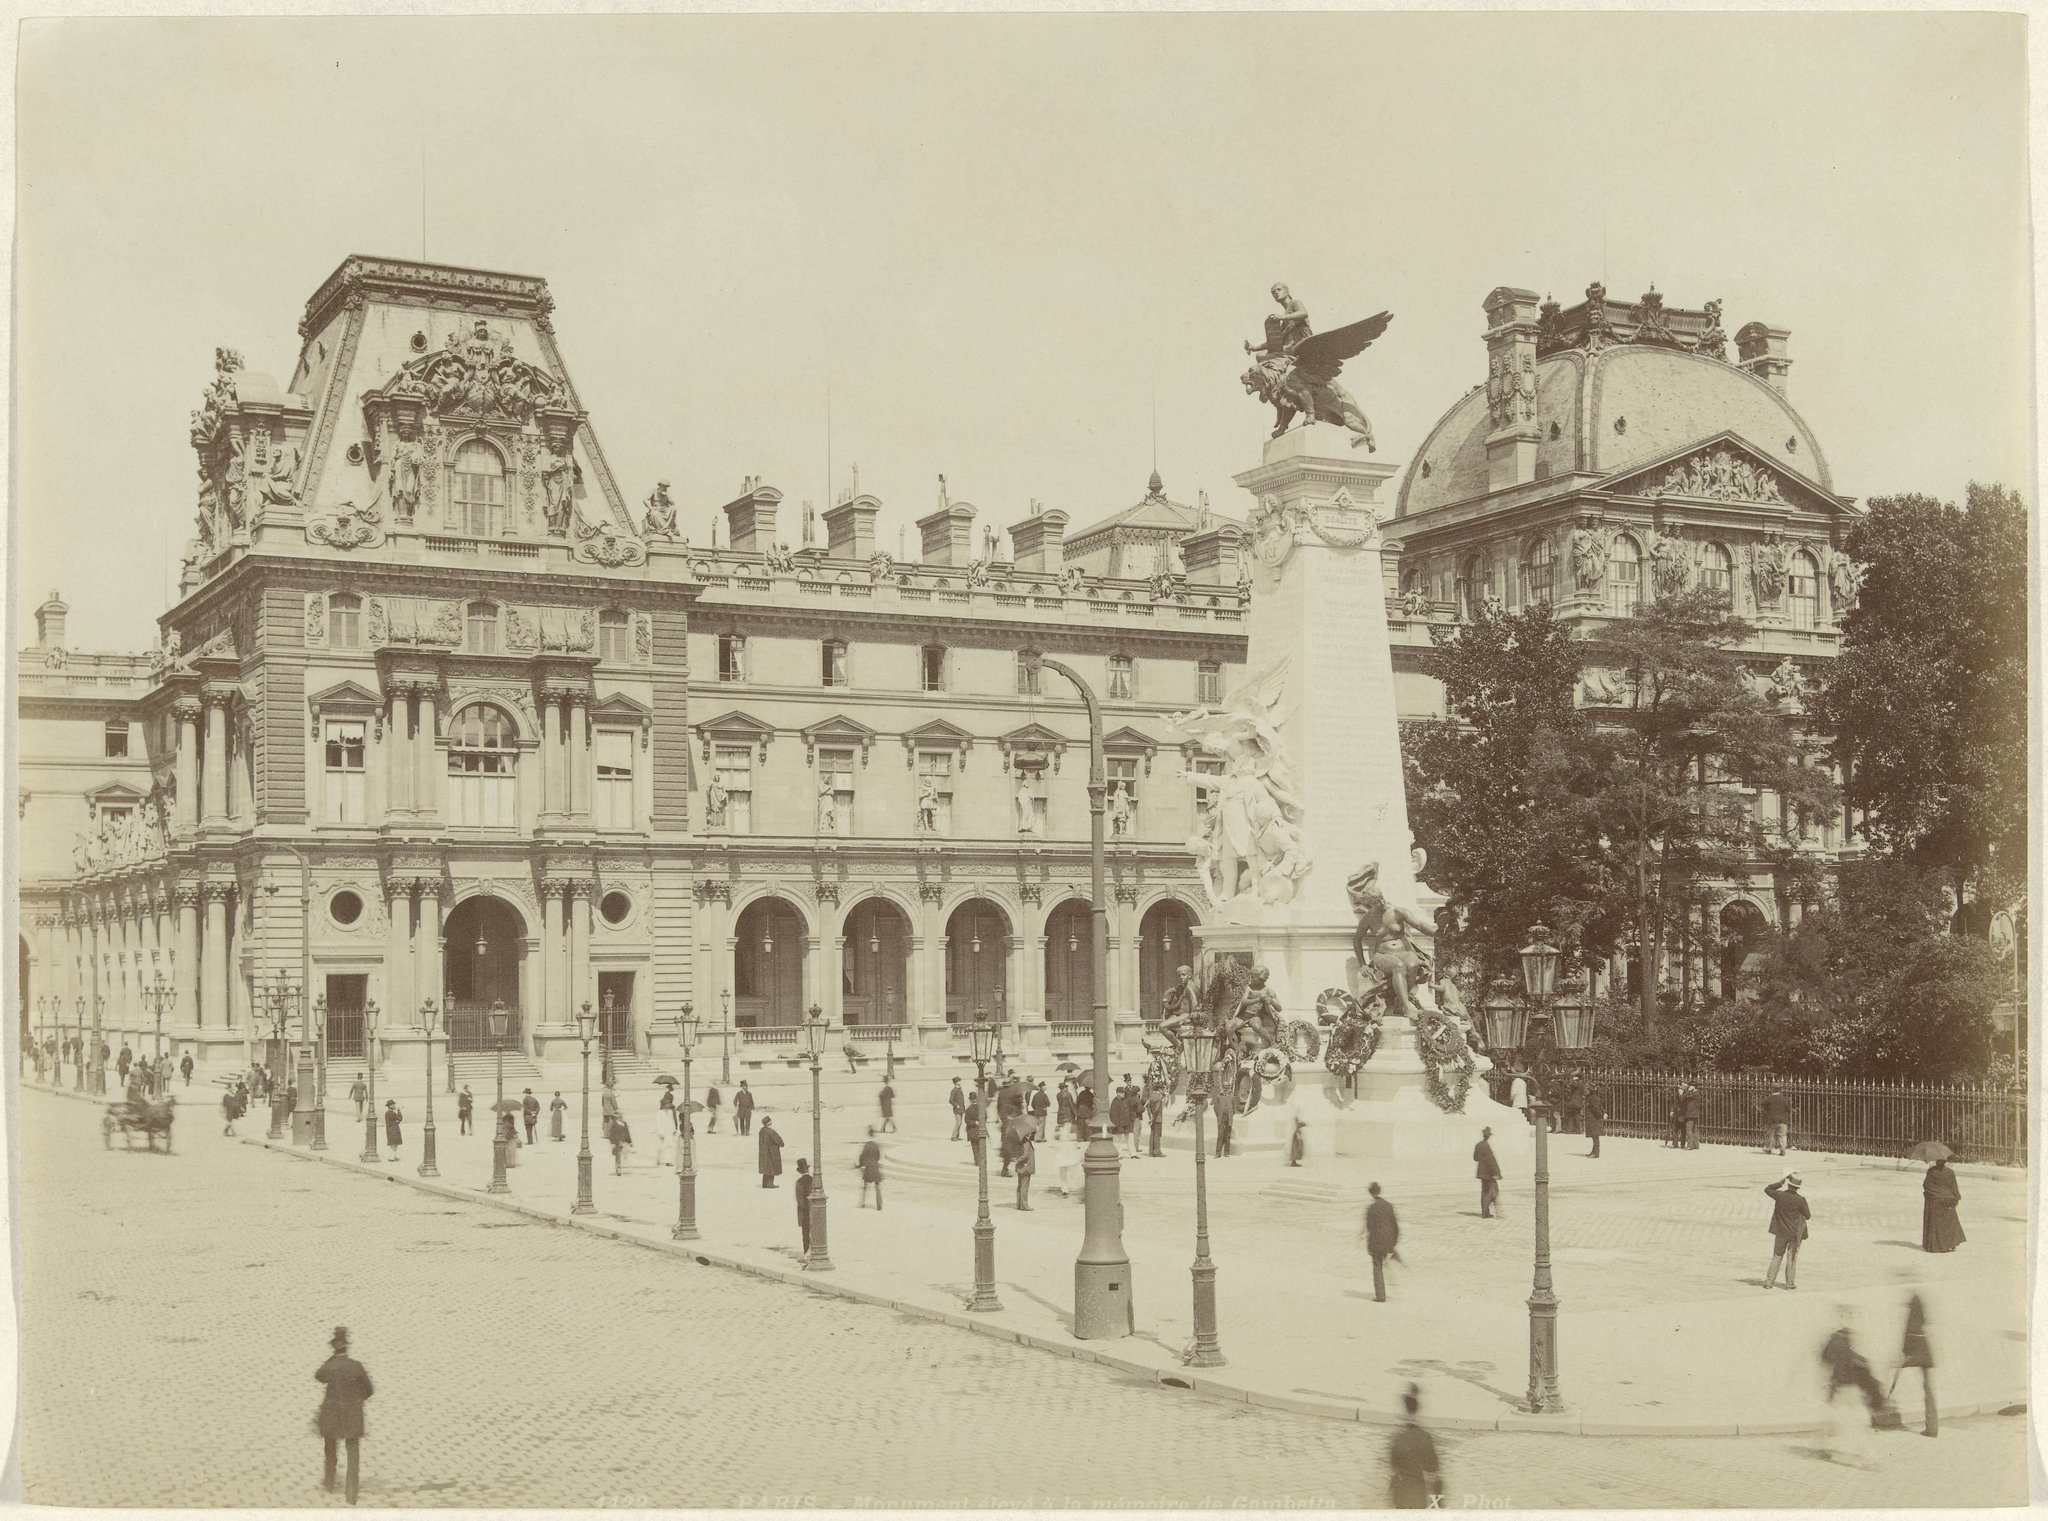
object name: photograph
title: Paris - Monument élevé à la memoire de Gambetta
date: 1888-1900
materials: paper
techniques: albumen print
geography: paris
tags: square, place, circus, etc., monument, statue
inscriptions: inscription: ‘1122 Paris - Monument élevé à la memoire de Gambetta X. Phot.’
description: Tussen 1887 en ca. 1900 werkten Neurdein frères onder andere onder de naam 'X phot.'.